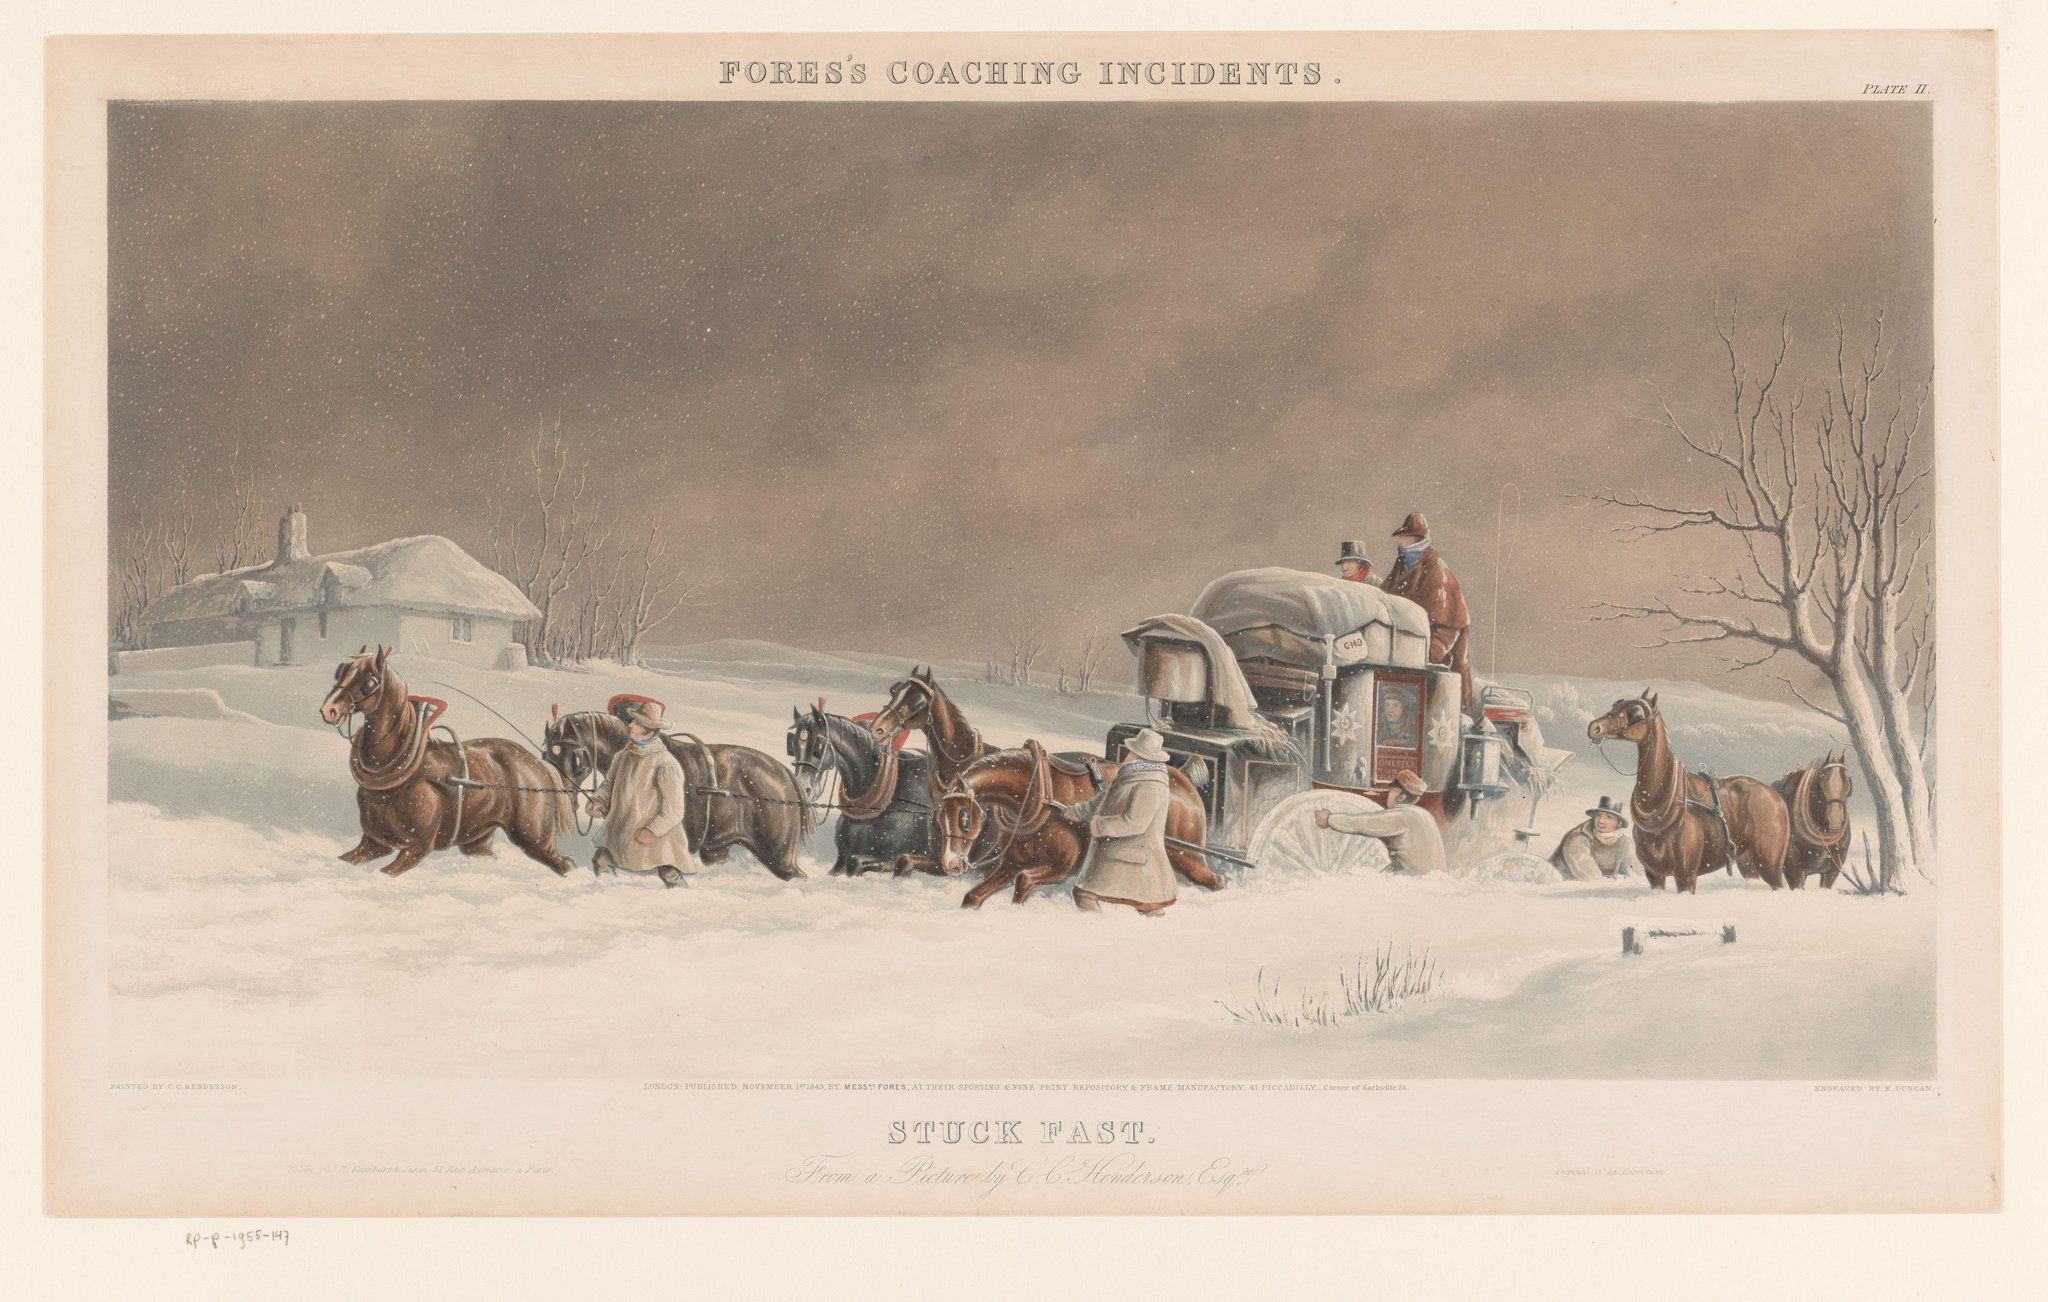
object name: print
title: Fores's coaching incidents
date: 1811-1843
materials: paper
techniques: aquatint, hand coloring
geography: paris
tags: snow, four-wheeled vehicle drawn by more than three animals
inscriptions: date